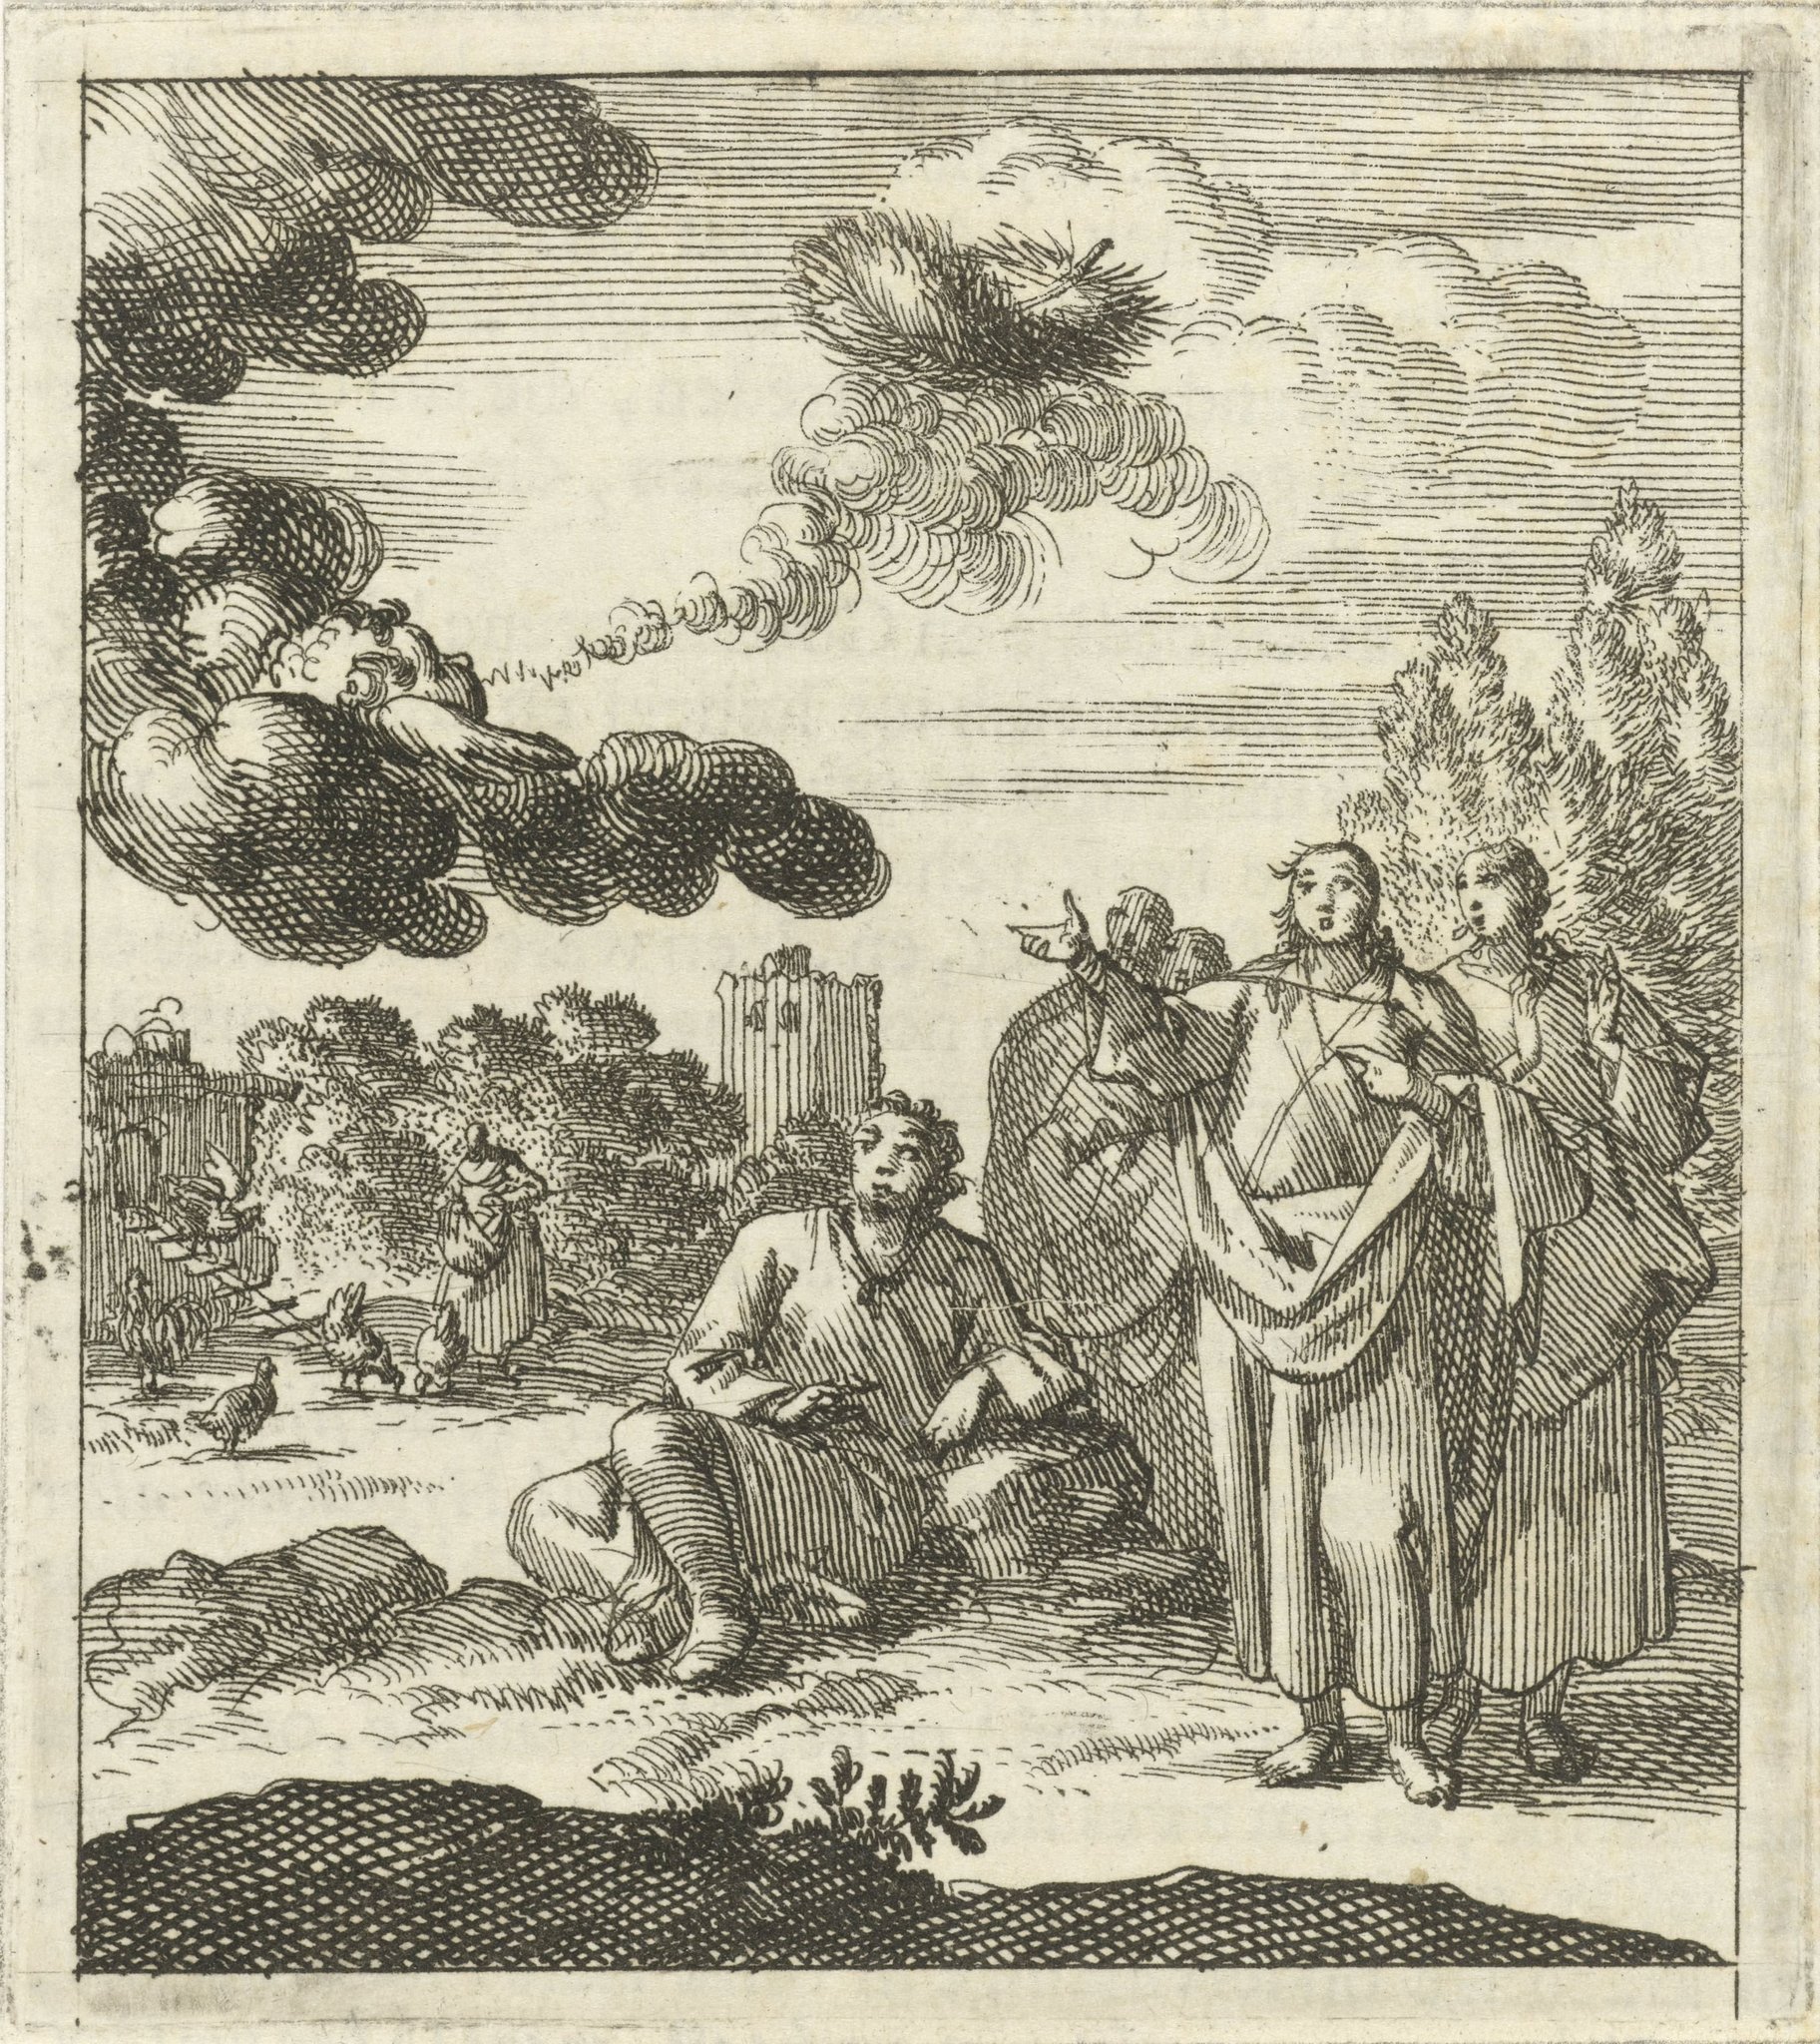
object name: print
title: Hoe minder aard', hoe meerder vaart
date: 1689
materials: paper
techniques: etching, letterpress printing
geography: amsterdam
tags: cherubs, i.e. children's heads with wings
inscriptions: collector's mark: Lugt 2228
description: Illustratie uit: Huygen, Pieter. De beginselen van Gods koninkryk in den mensch uitgedrukt in zinnebeelden. Amsterdam: wed. Arentsz. Pieter (II), 1689, p. 104.